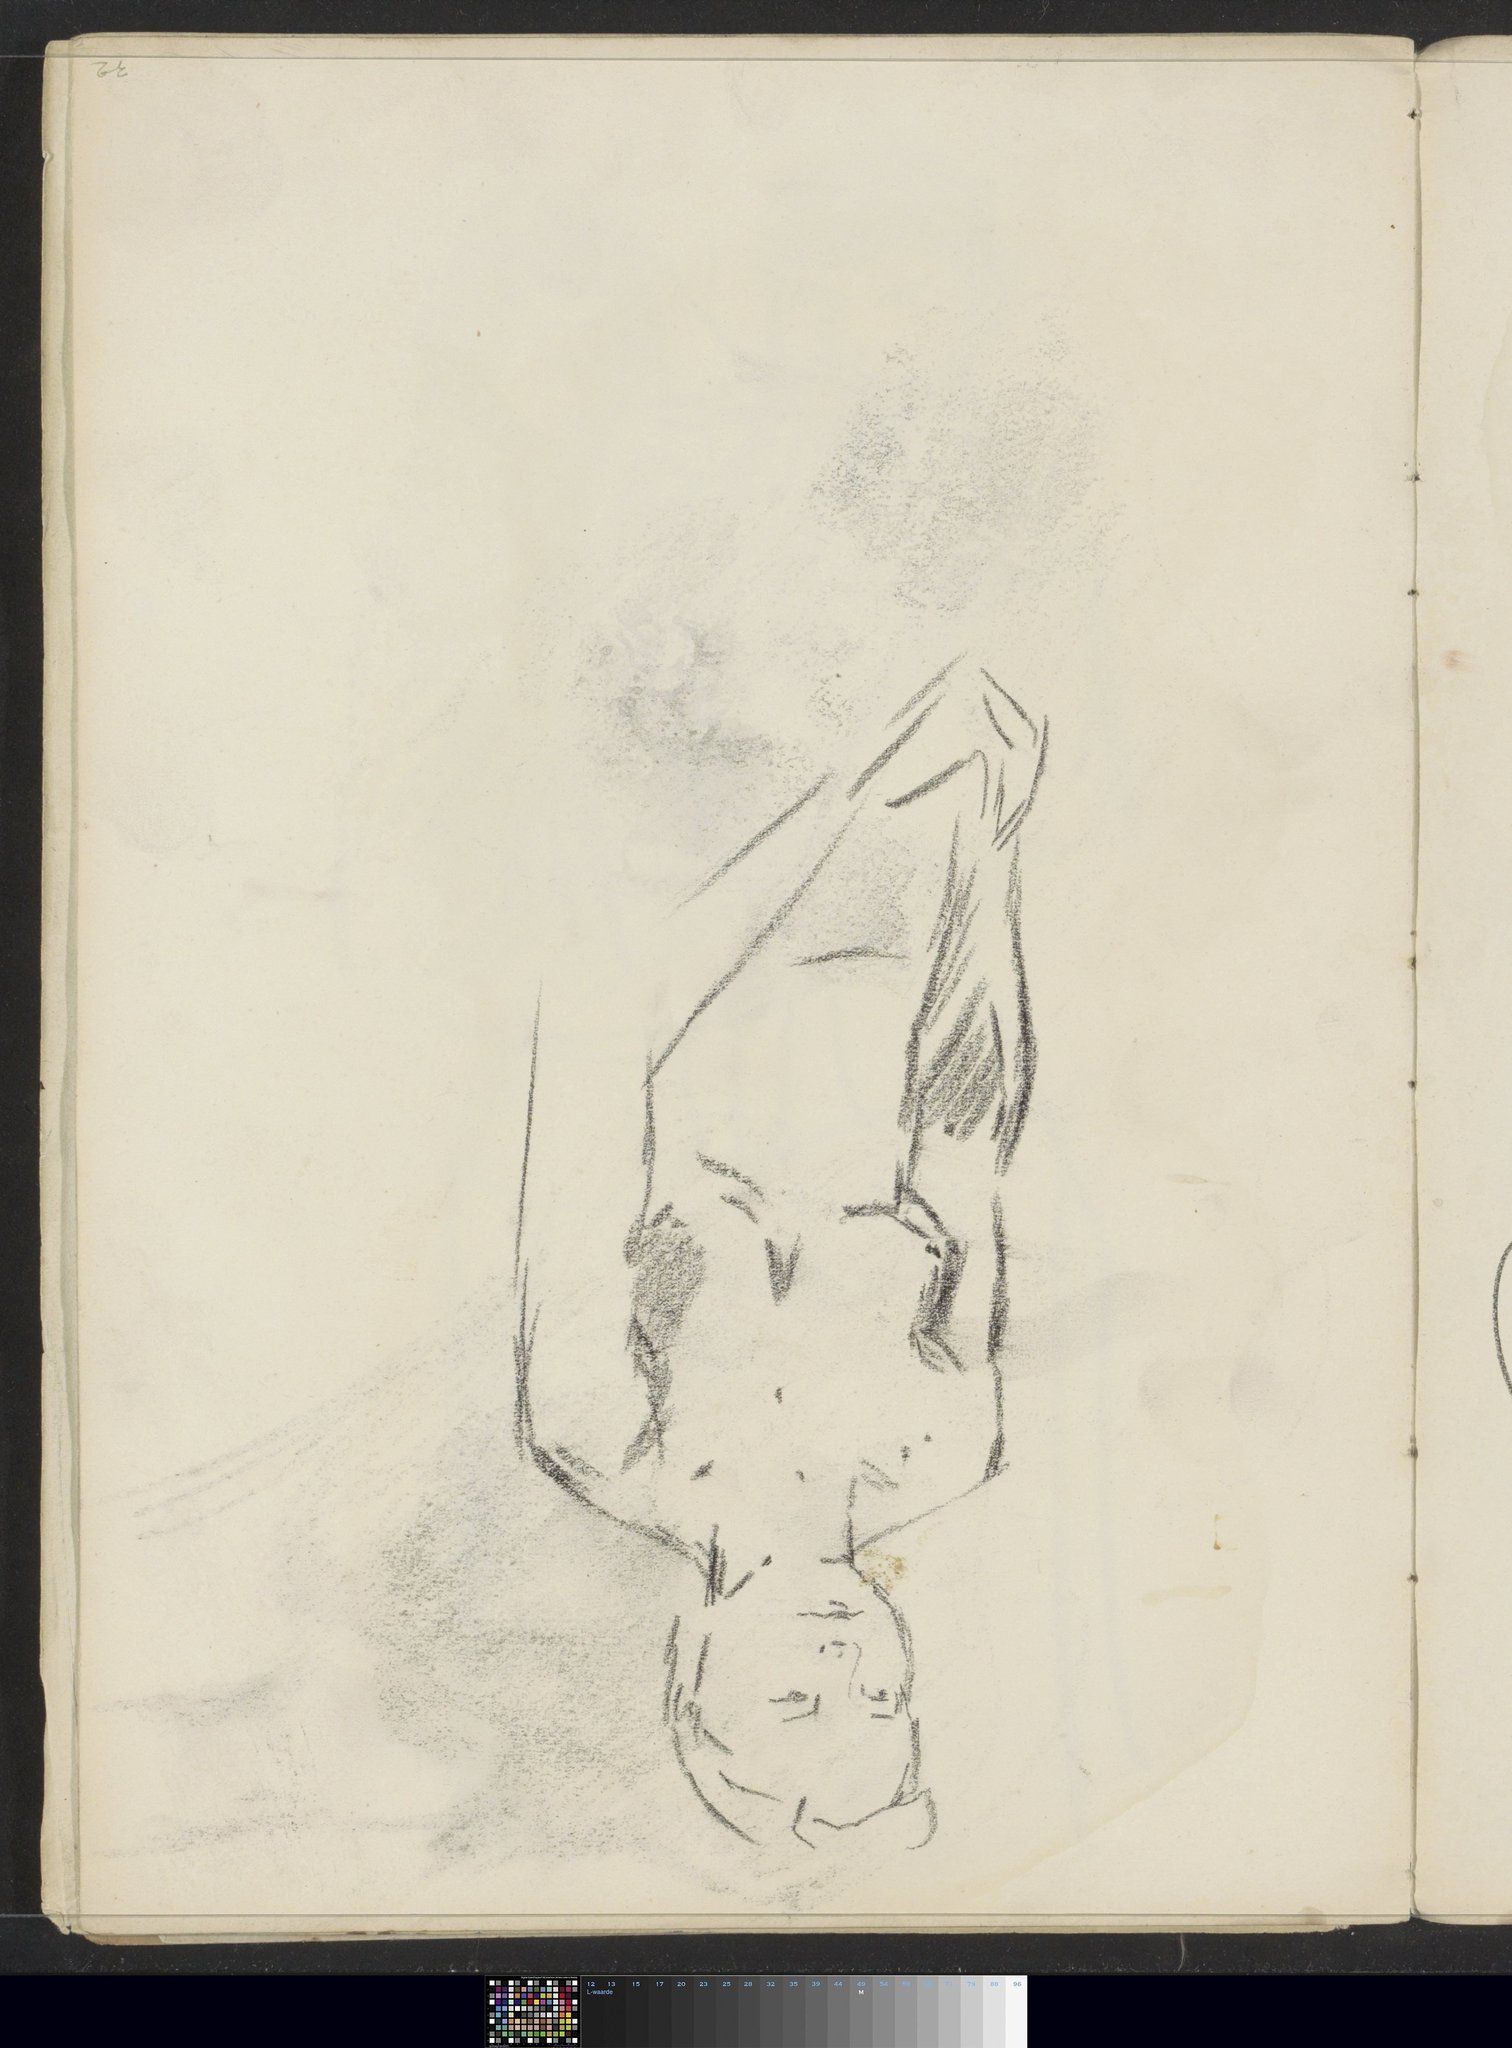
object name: sketchbook leaf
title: Vrouwelijk naakt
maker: isaac israels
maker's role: draughtsman, painter, print maker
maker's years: 1865-1934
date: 1886-1934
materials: chalk, paper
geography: amsterdam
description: Blad 19 verso uit schetsboek LXVI-B met 25 bladen.